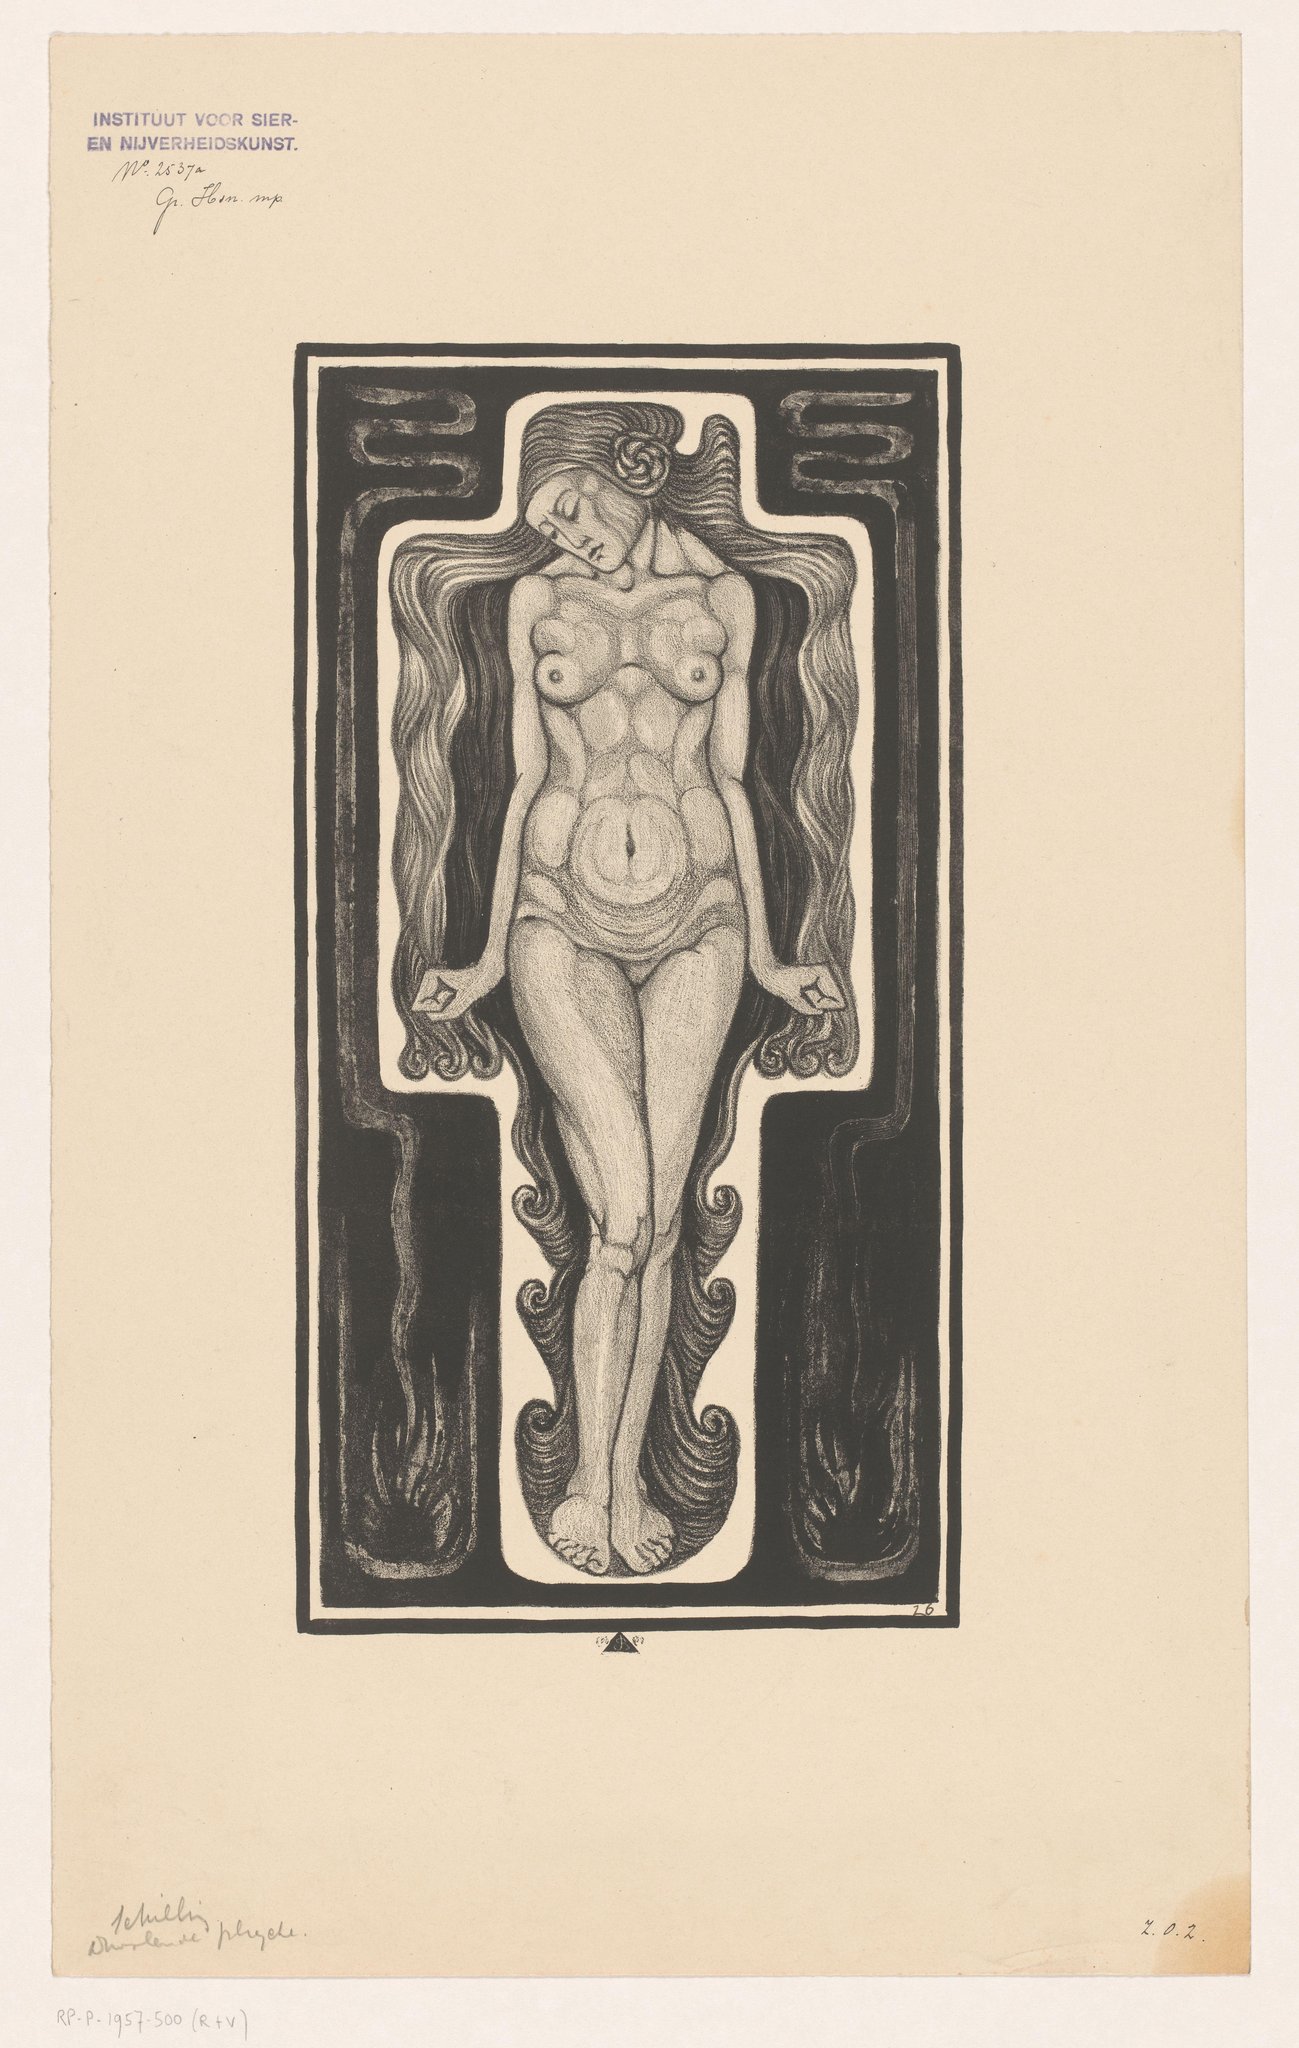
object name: print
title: Staande naakte vrouw met lang haar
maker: henk schilling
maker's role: print maker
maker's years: 1893-1942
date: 1926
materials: paper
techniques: lithograph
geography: netherlands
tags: the (nude) human figure; 'corpo humano' (ripa) - aa - female human figure (+ standing)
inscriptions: inscription: ‘No. 2537a Gr. Hsn. mp.’, stamp: ‘Instituut voor sier- en nijverheidskunst’